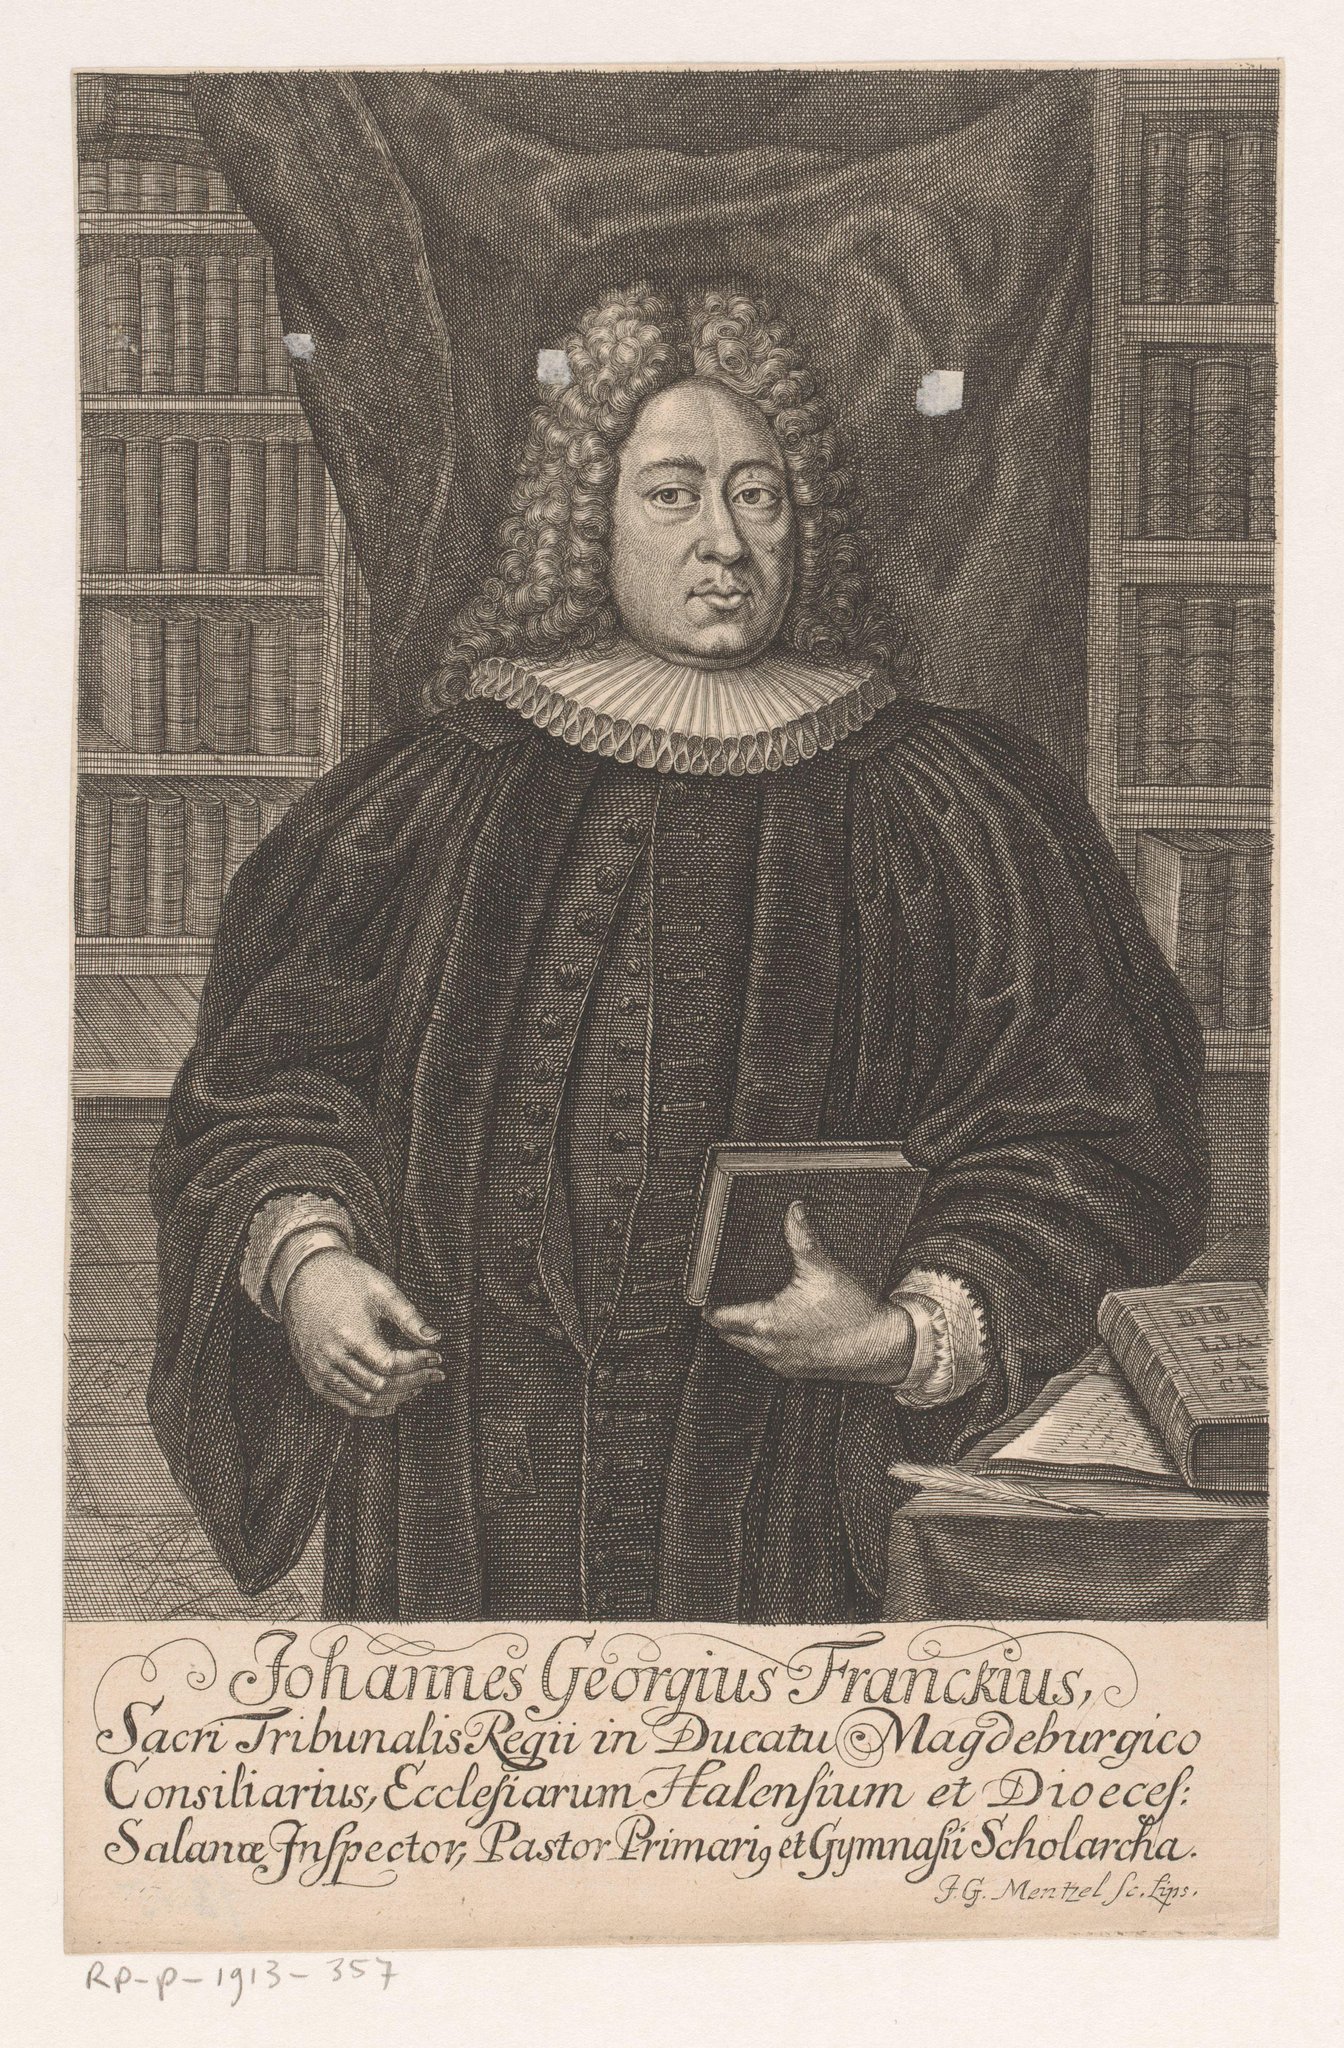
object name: print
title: Portret van Johannes Georgius Franckius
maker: johann georg mentzel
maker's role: print maker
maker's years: 1677-1743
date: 1687-1743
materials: paper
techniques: engraving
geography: leipzig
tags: bookshelves, theologian, historical persons, book, wig, the bible as a book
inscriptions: collector's mark: Lugt 2228